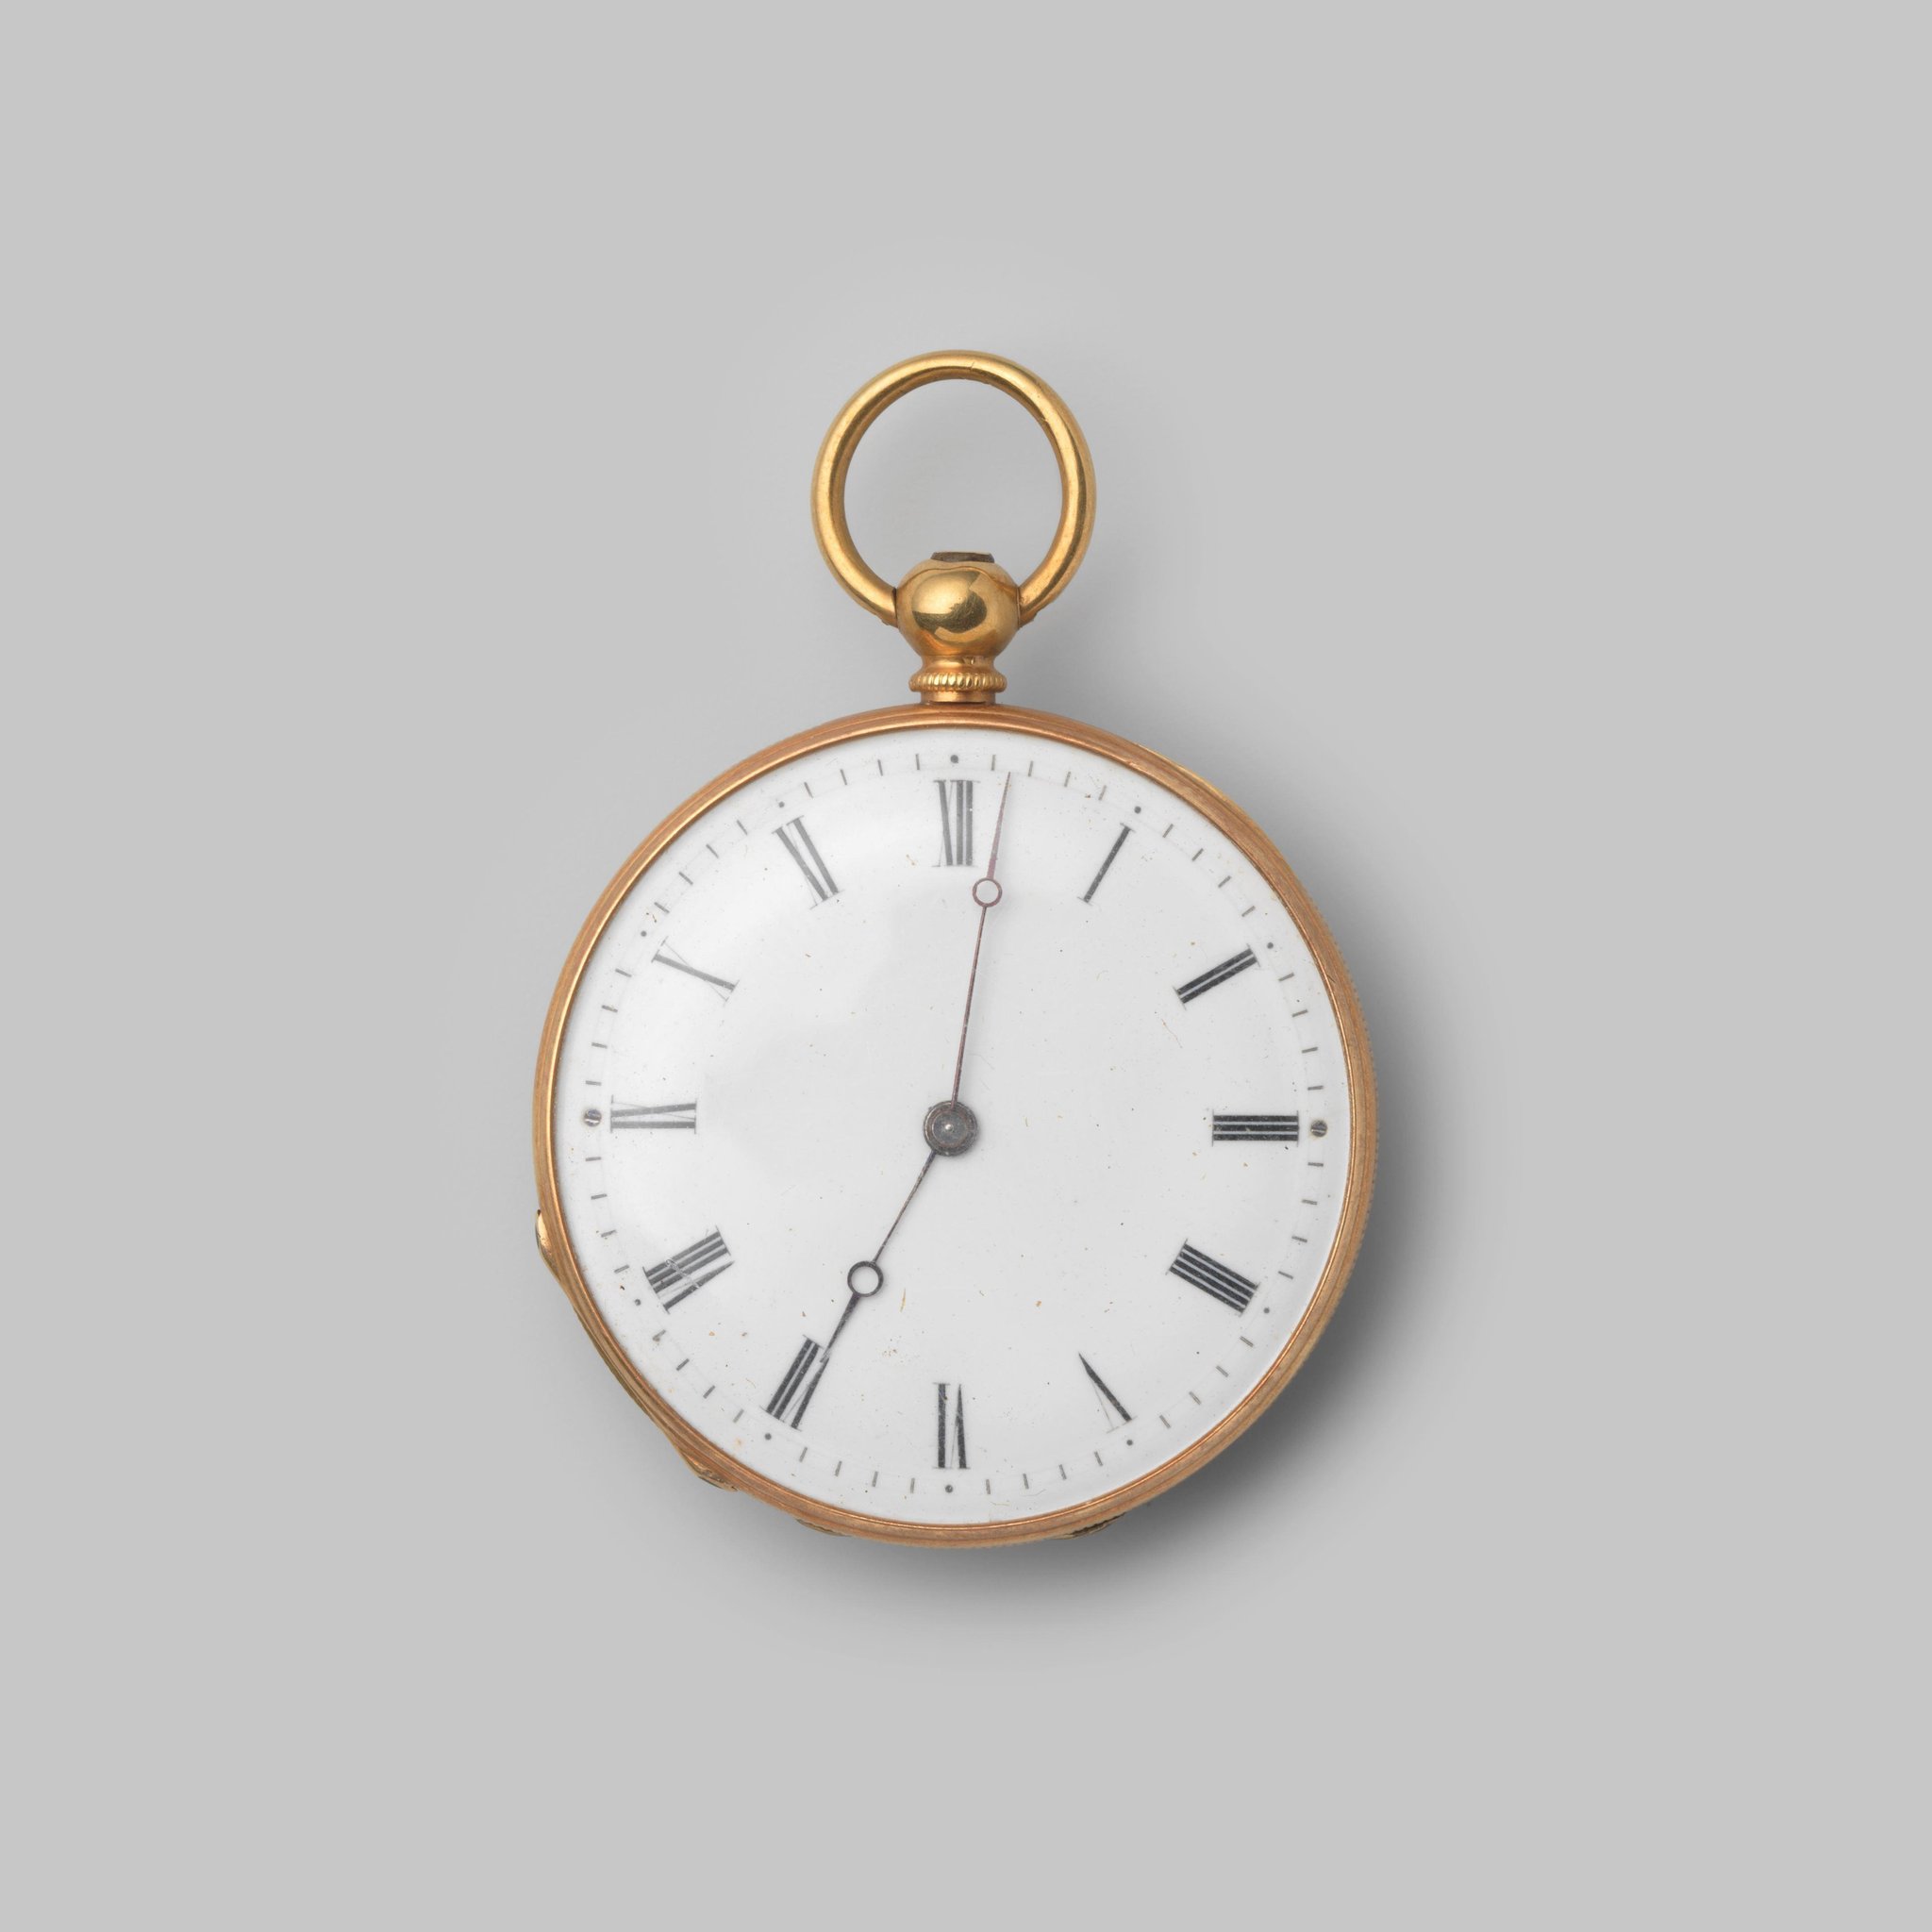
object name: jewellery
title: Horloge van goud met witte geëmailleerde wijzerplaat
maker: Anonymous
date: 1850-1900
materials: gemstone, diamond, gold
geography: geneva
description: Horloge van goud met wit geëmailleerde wijzerplaat. De achterbodem van de kast is versierd met amethisten en diamanten.